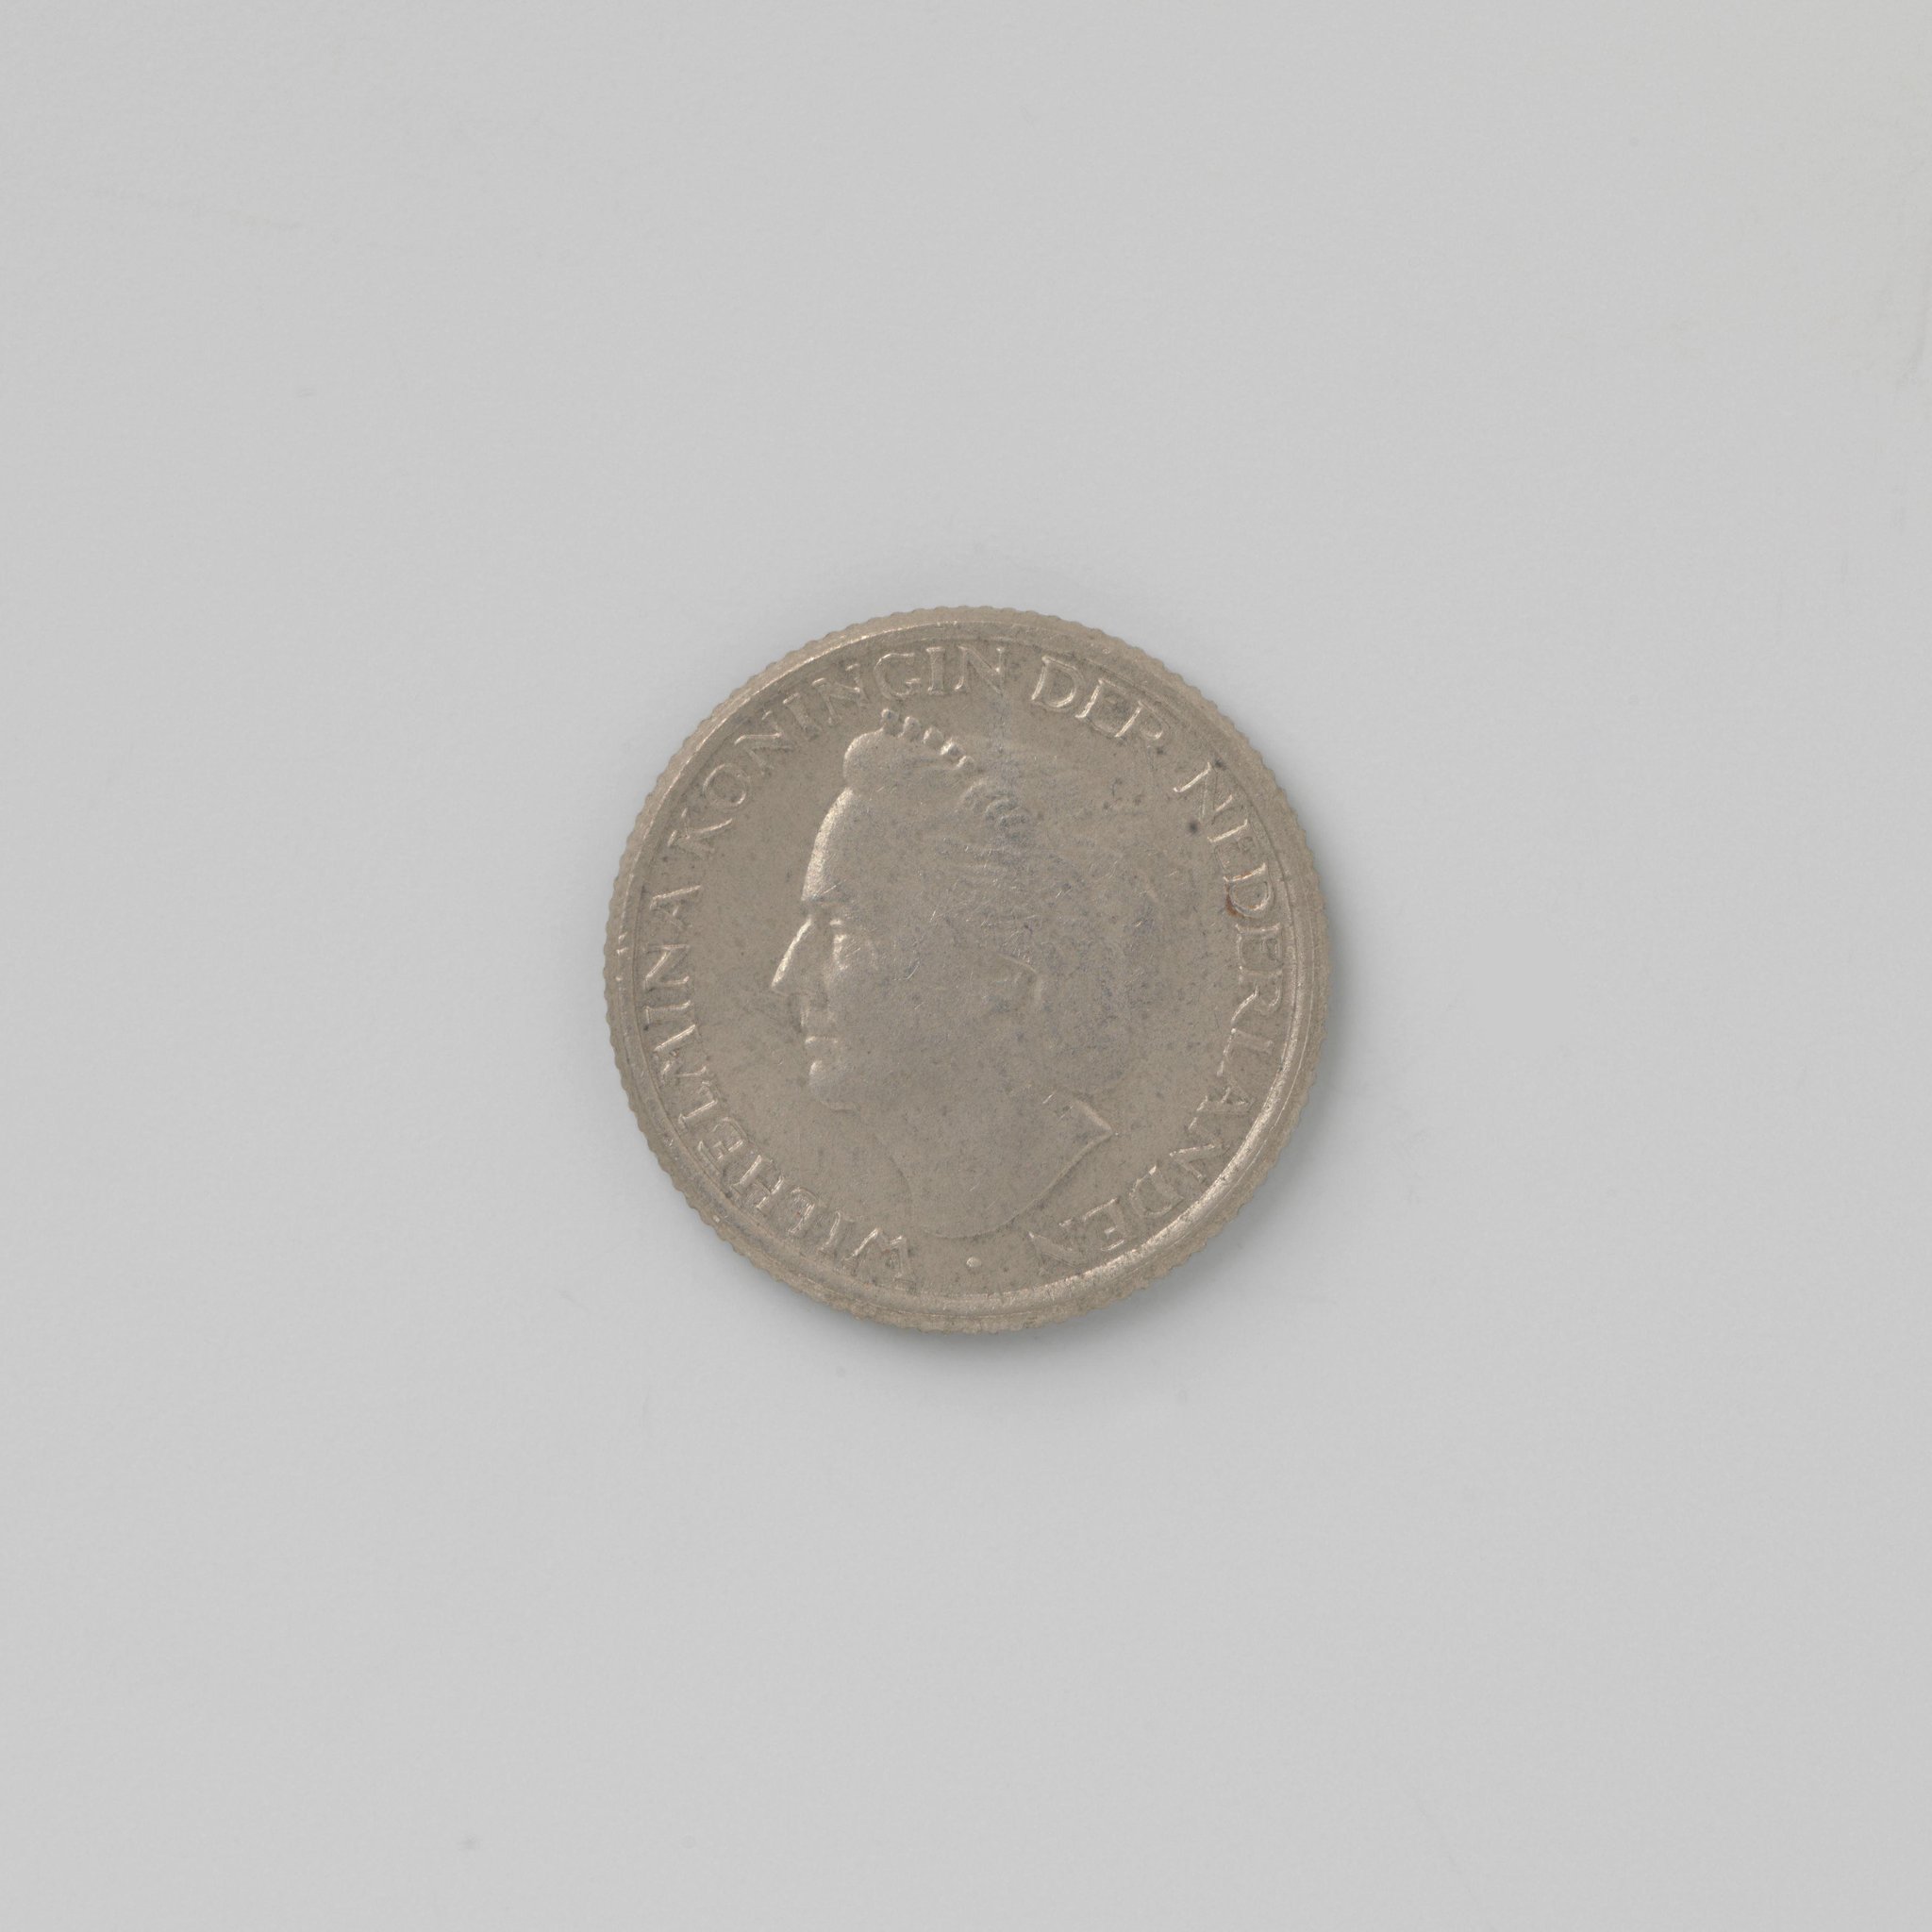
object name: coin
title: Nederlandse 10 cent,1948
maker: wilhelmina of the netherlands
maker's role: print maker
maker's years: 1880-1962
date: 1948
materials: nickel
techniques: striking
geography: utrecht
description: Nikkelen munt. Voorzijde: hoofd naar links. Keerzijde: kroon, daaronder, tussen jaartal, waarde-aanduiding 10 cent. Kartelrand.